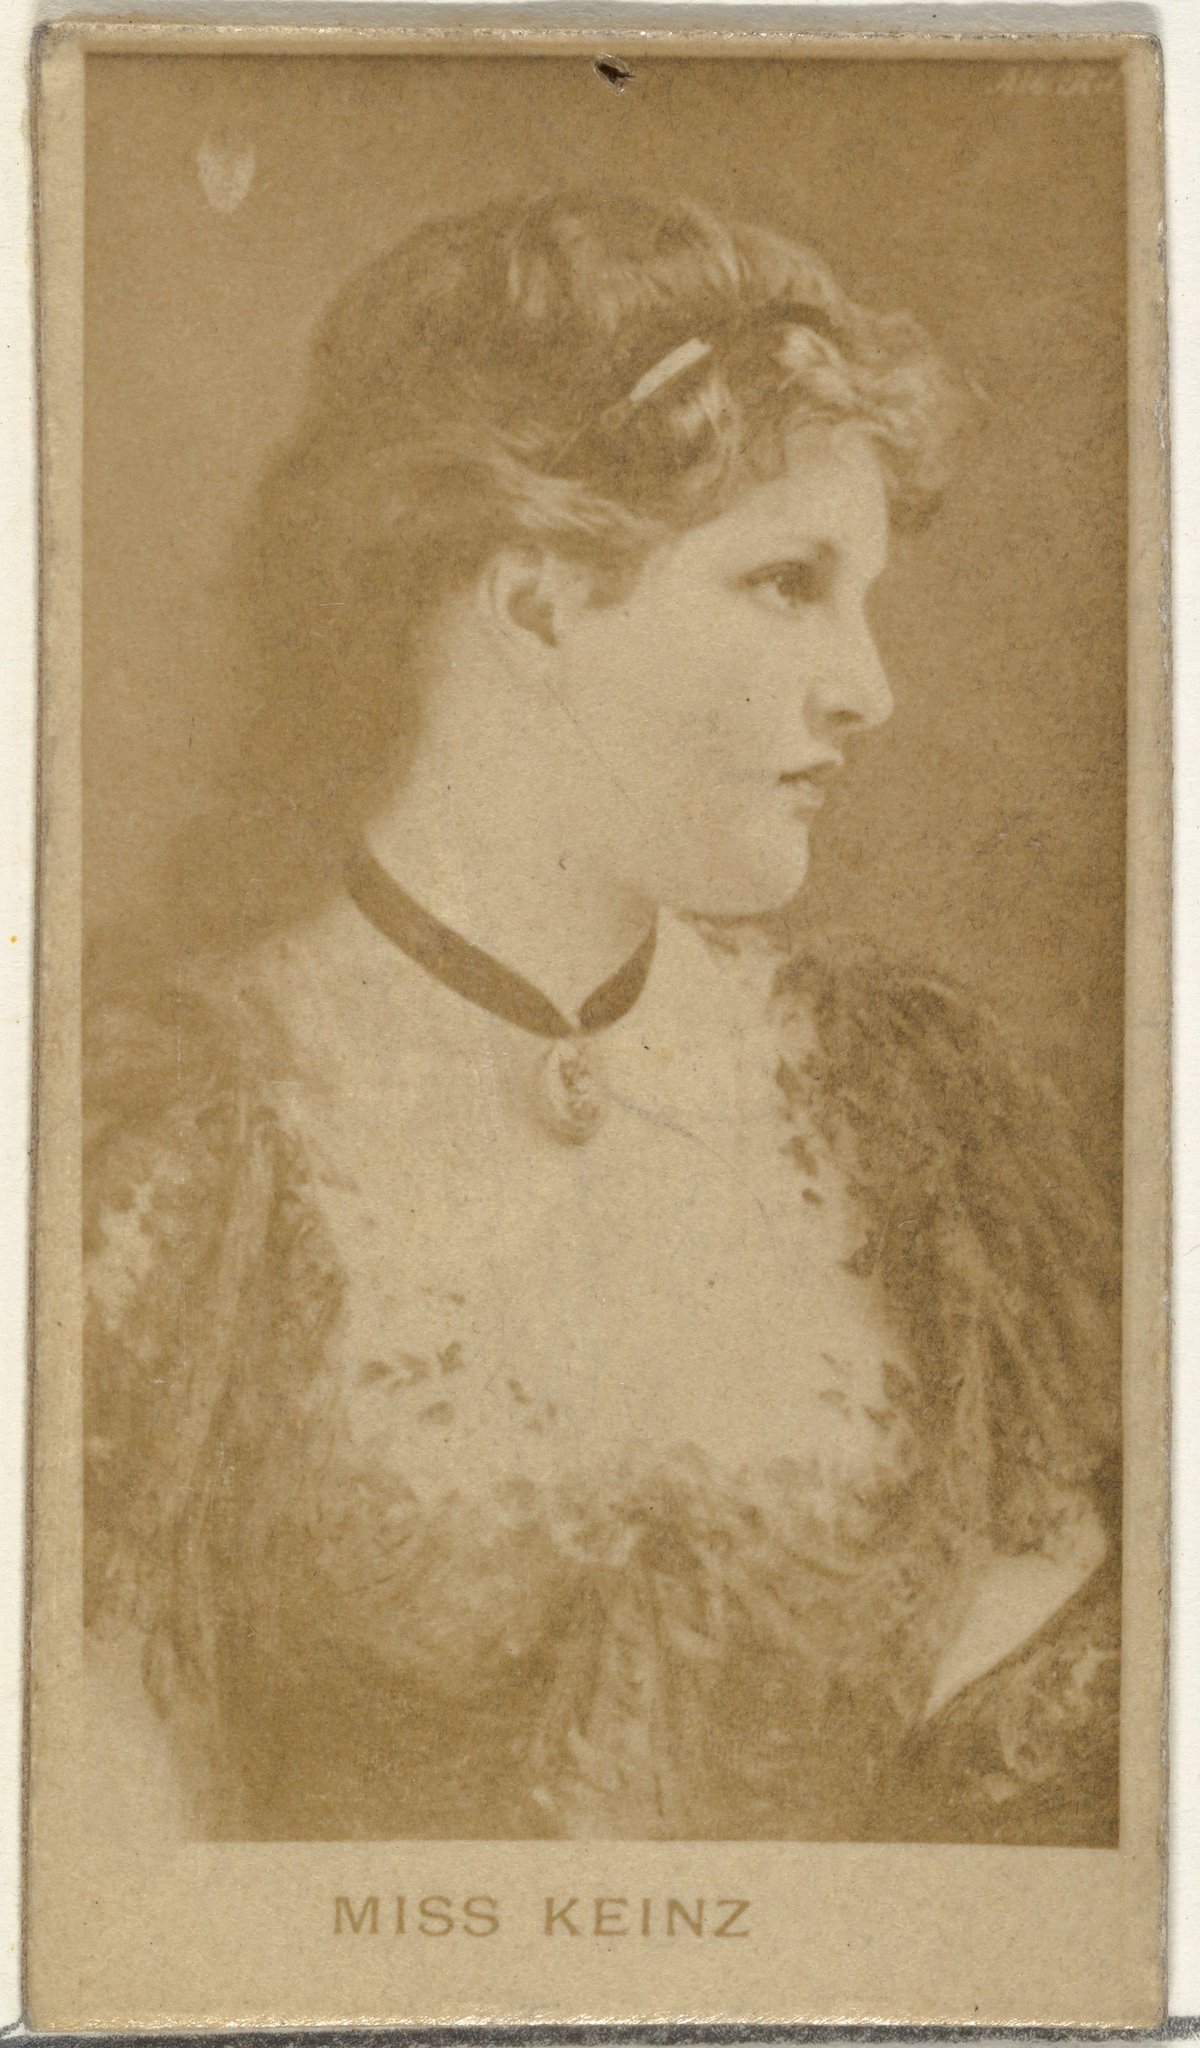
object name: photograph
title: Miss Keinz, from the Actors and Actresses series (N145-8) issued by Duke Sons & Co. to promote Duke Cigarettes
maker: w. duke, sons & co.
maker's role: publisher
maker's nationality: american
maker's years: 1870-1920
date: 1891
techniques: albumen silver print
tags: portraits,women,actresses